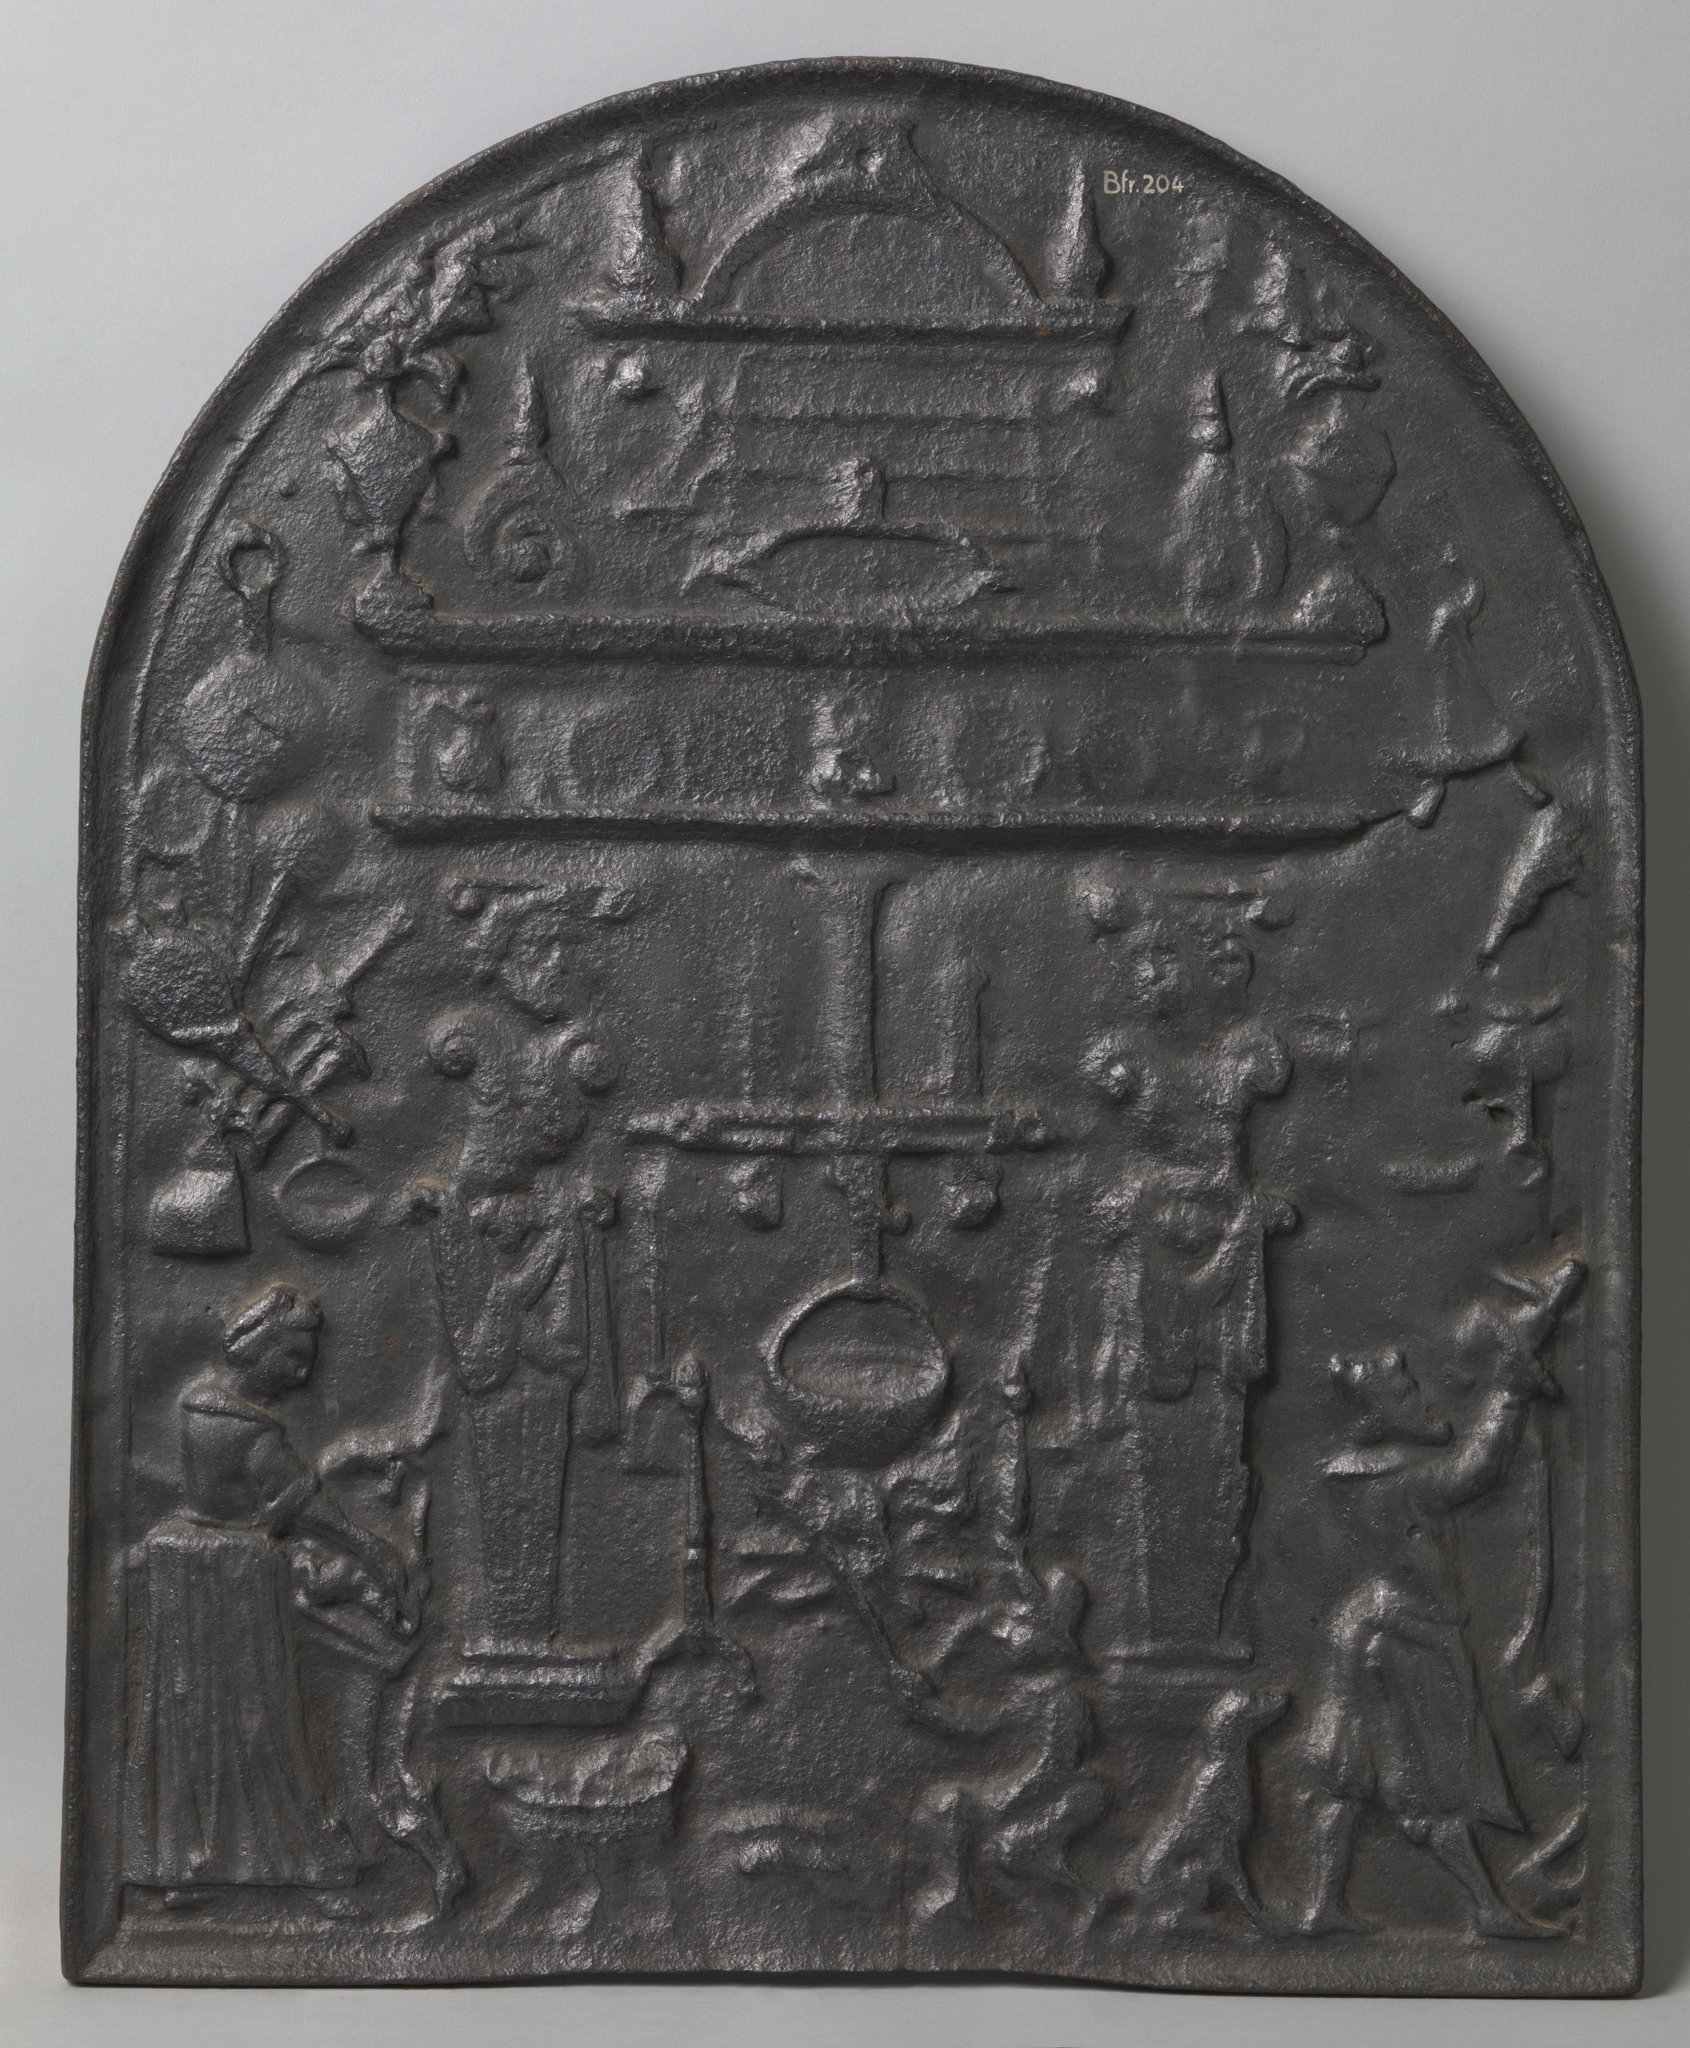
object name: fireback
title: Haardplaat met een voorstelling van een keukeninterieur met enkele figuren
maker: Anonymous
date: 1600-1625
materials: iron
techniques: casting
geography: germany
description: Haardplaat van gietijzer, met halfronde bovenzijde. De haardplaat toont een interieur, met centraal een open haard met een ketel en ander kookgerei. De open haard heeft aan weerszijden kariatiden. Voor de open haard zitten een jongen en een hond. Op de voorgrond liggen gebruiksgoederen en er zitten een kat en een hond. Links van de open haard staat een vrouw met voor haar een kleine hond, rechts van de staat een man. Boven hen hangt meer keukengerei.